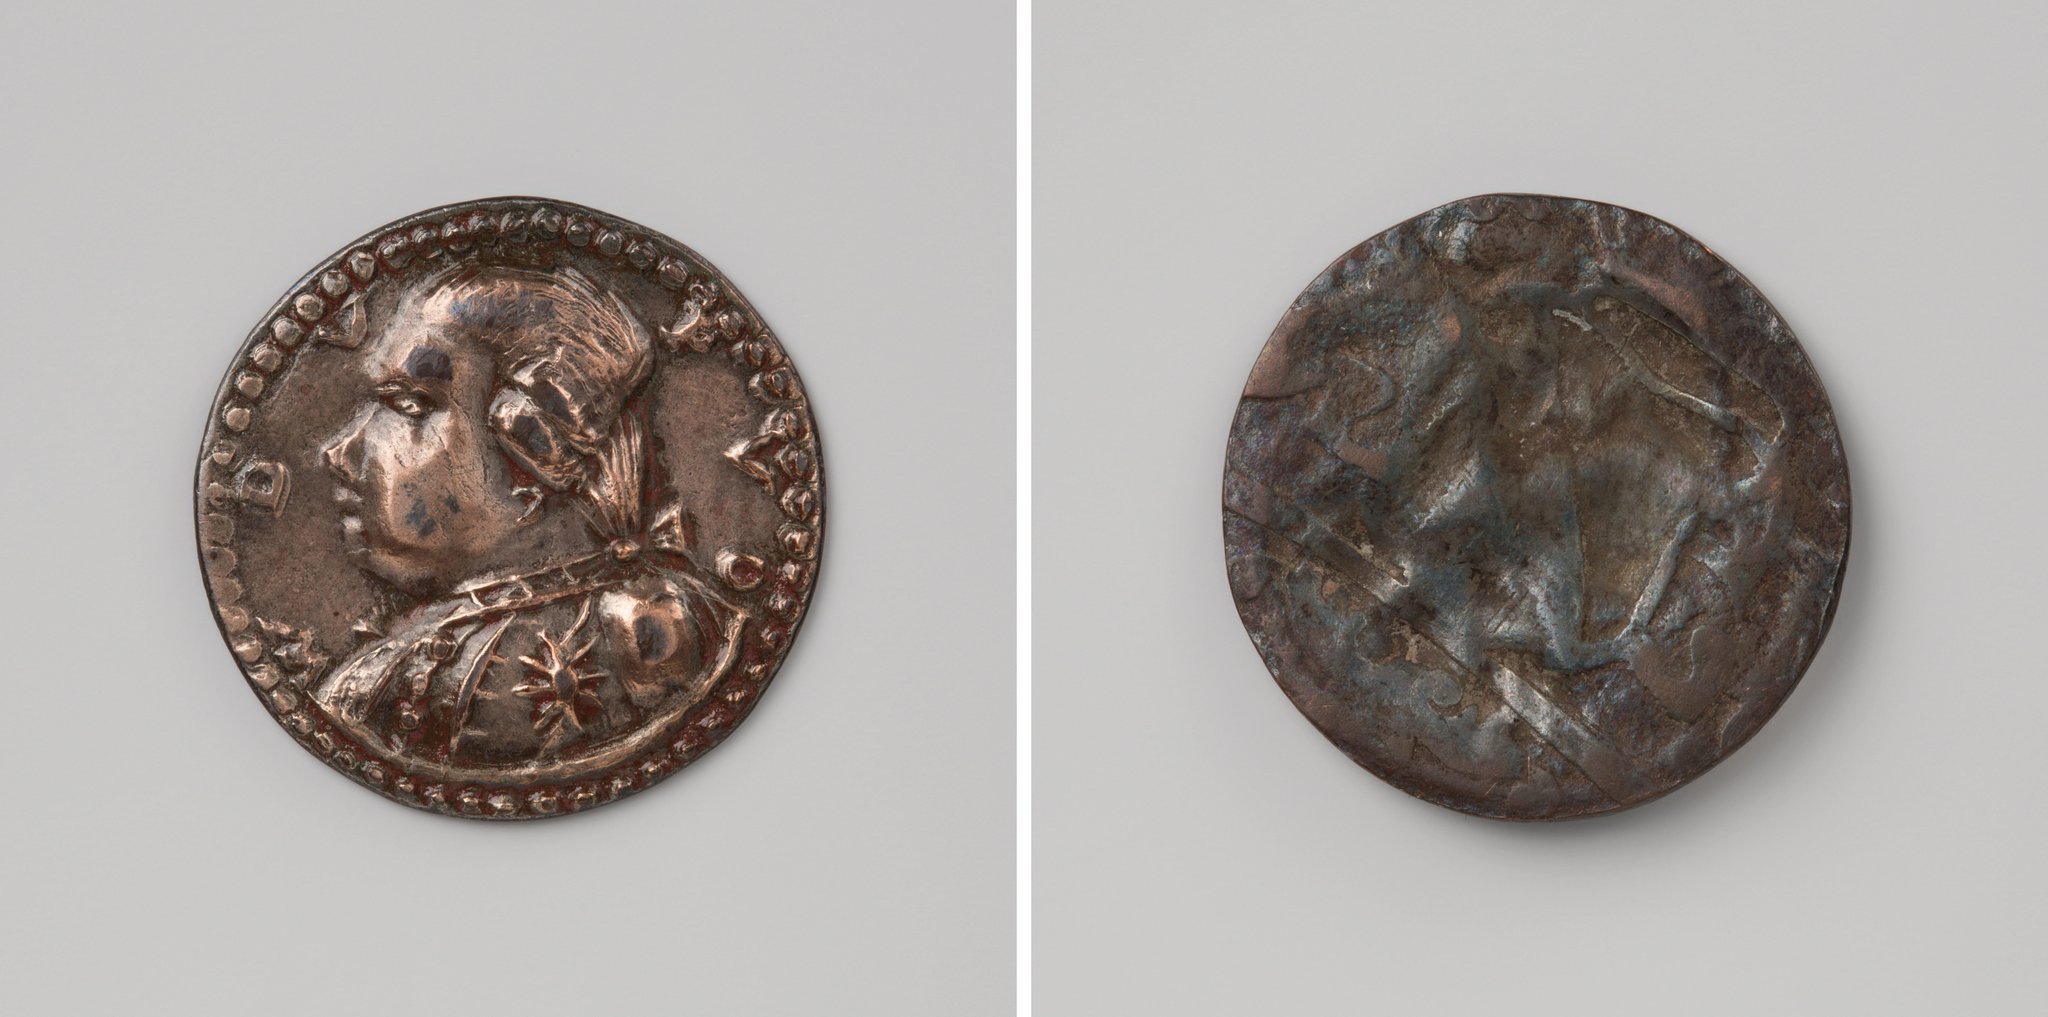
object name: coin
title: Silbergrosschen, Willem V, prins van Oranje-Nassau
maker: Anonymous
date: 1767-1787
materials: silver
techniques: striking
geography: germany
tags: the hague, william v (prince of orange)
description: Zilveren penning. Voorzijde: borststuk man binnen omschrift. Keerzijde: afgesleten afdruk van munt